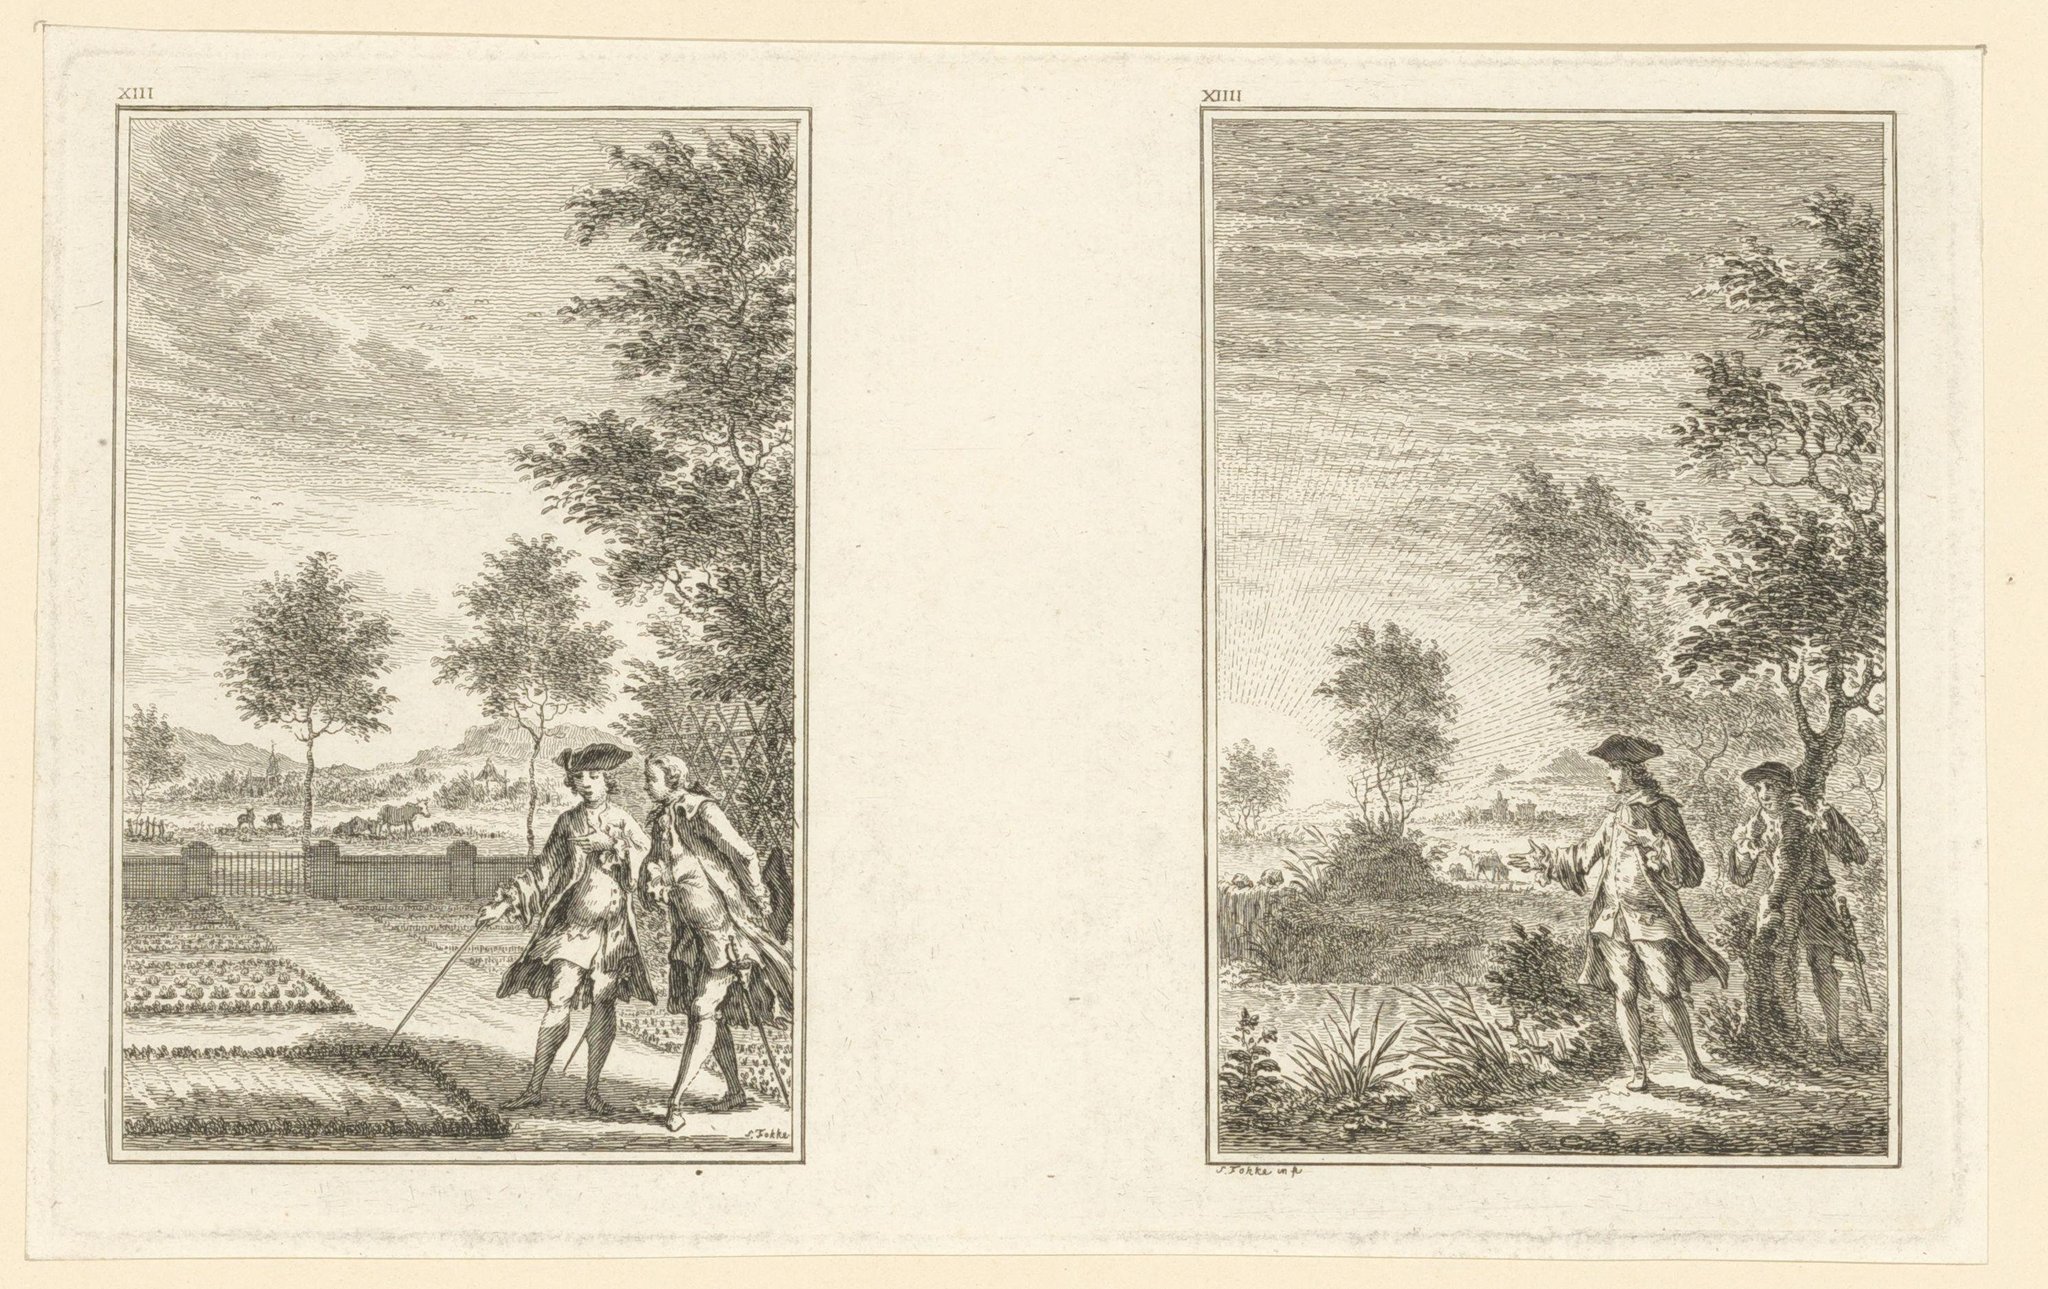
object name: print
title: Twee mannen bij een moestuin en een vijver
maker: simon fokke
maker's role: draughtsman, print maker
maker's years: 1712-1784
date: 1722-1784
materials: paper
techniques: etching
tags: garden, sunrise, garden pond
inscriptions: stamp, collector's mark: Lugt 1641, stamp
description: Twee voorstellingen van een plaat. Links twee mannen bij een moestuin. Op de achtergrond een koeien in een weiland. Rechtsboven deze voorstelling genummerd: XIII. Rechts twee mannen bij een vijver tijdens zonsopkomst. Rechtsboven de voorstelling genummerd: XIIII. Onderwerpsrubrieken binnen de Atlas Zeden en Gewoonten: Handel, nijverheid en verkeer, Buitenleven.